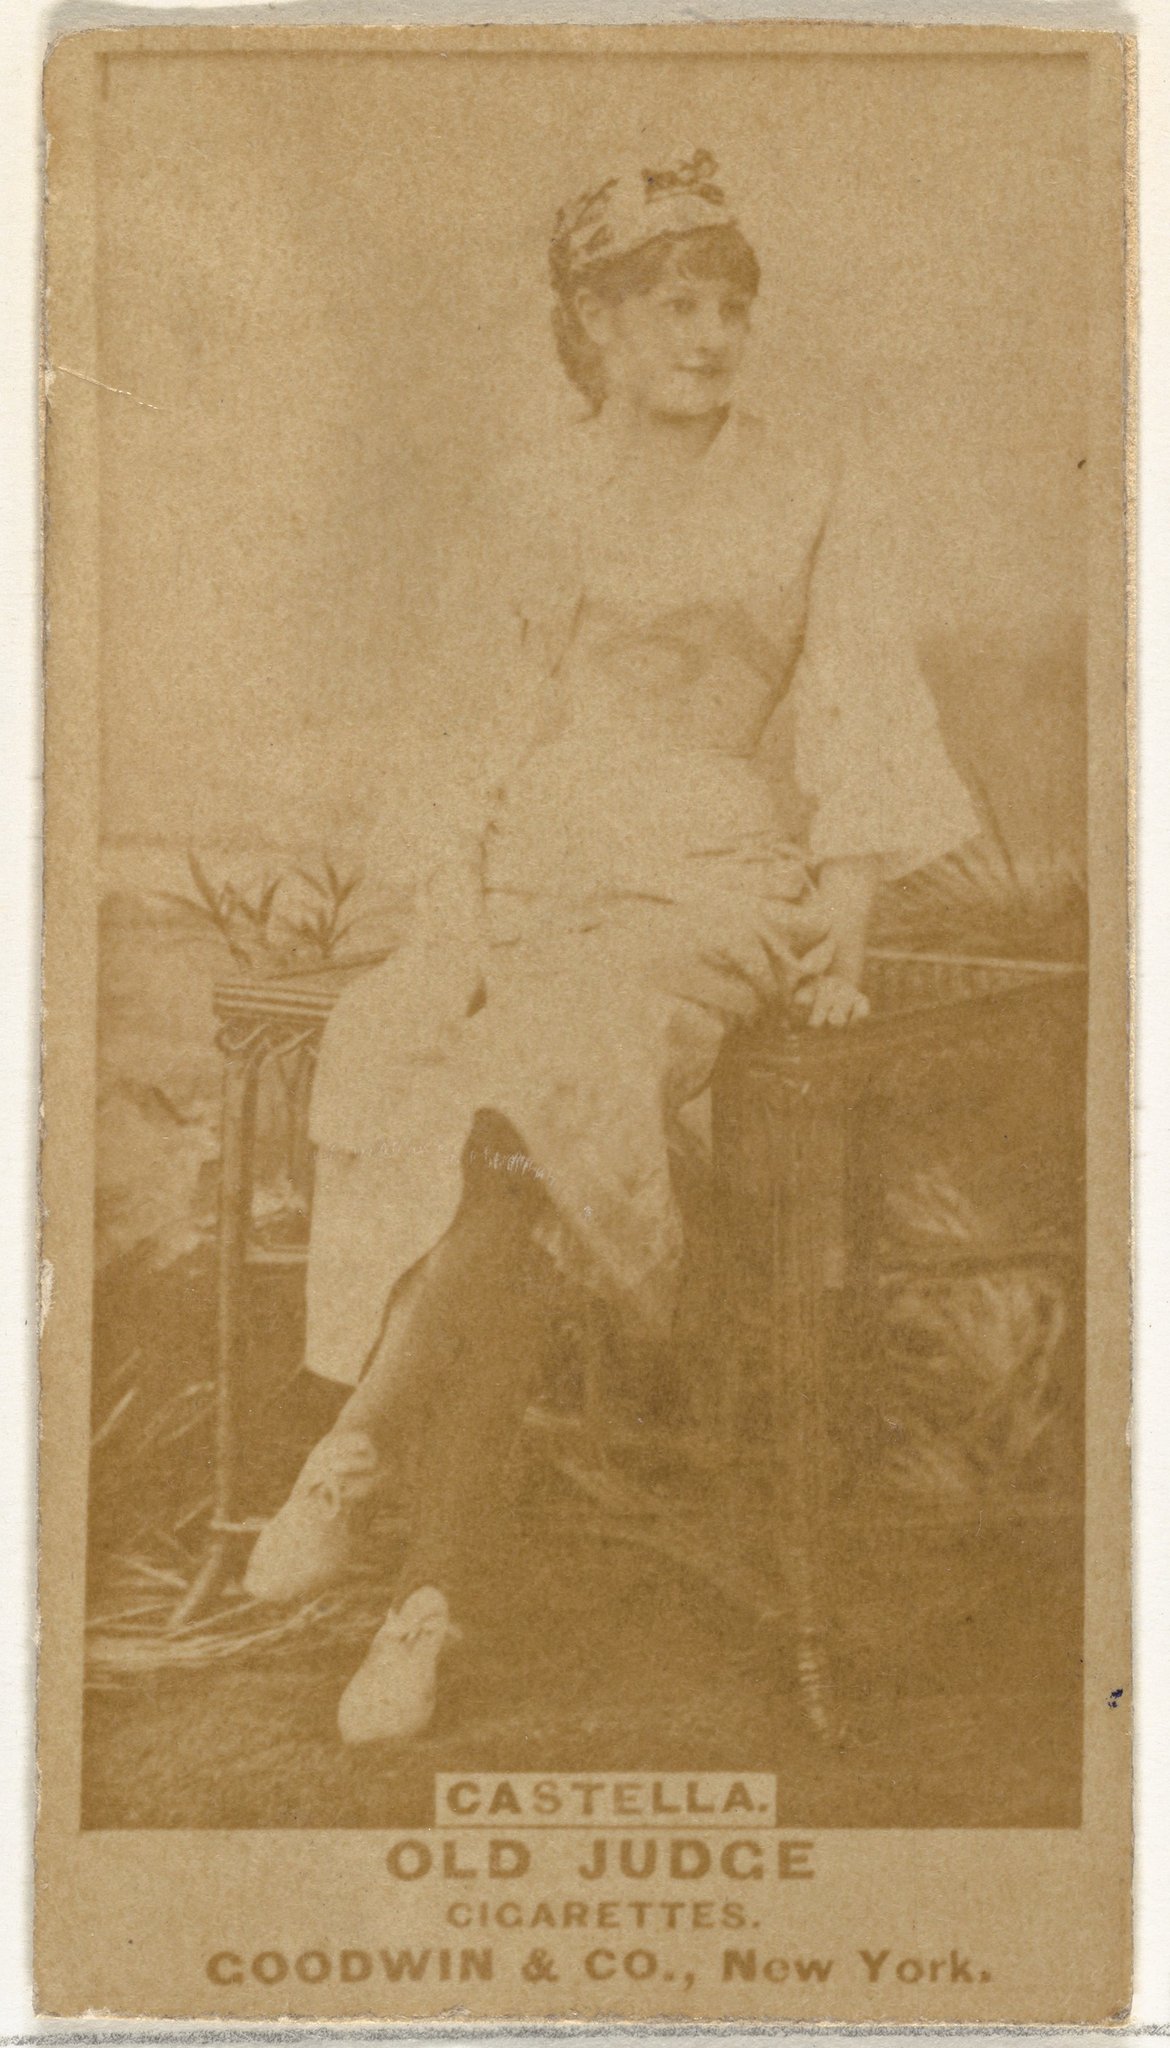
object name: photograph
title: Castella, from the Actors and Actresses series (N171) for Old Judge Cigarettes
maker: goodwin & company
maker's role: publisher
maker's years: 1850-1950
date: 1886-1890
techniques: albumen silver print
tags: portraits,women,actresses